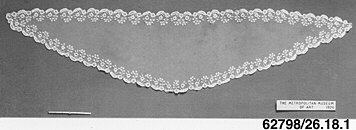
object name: fichu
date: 1820